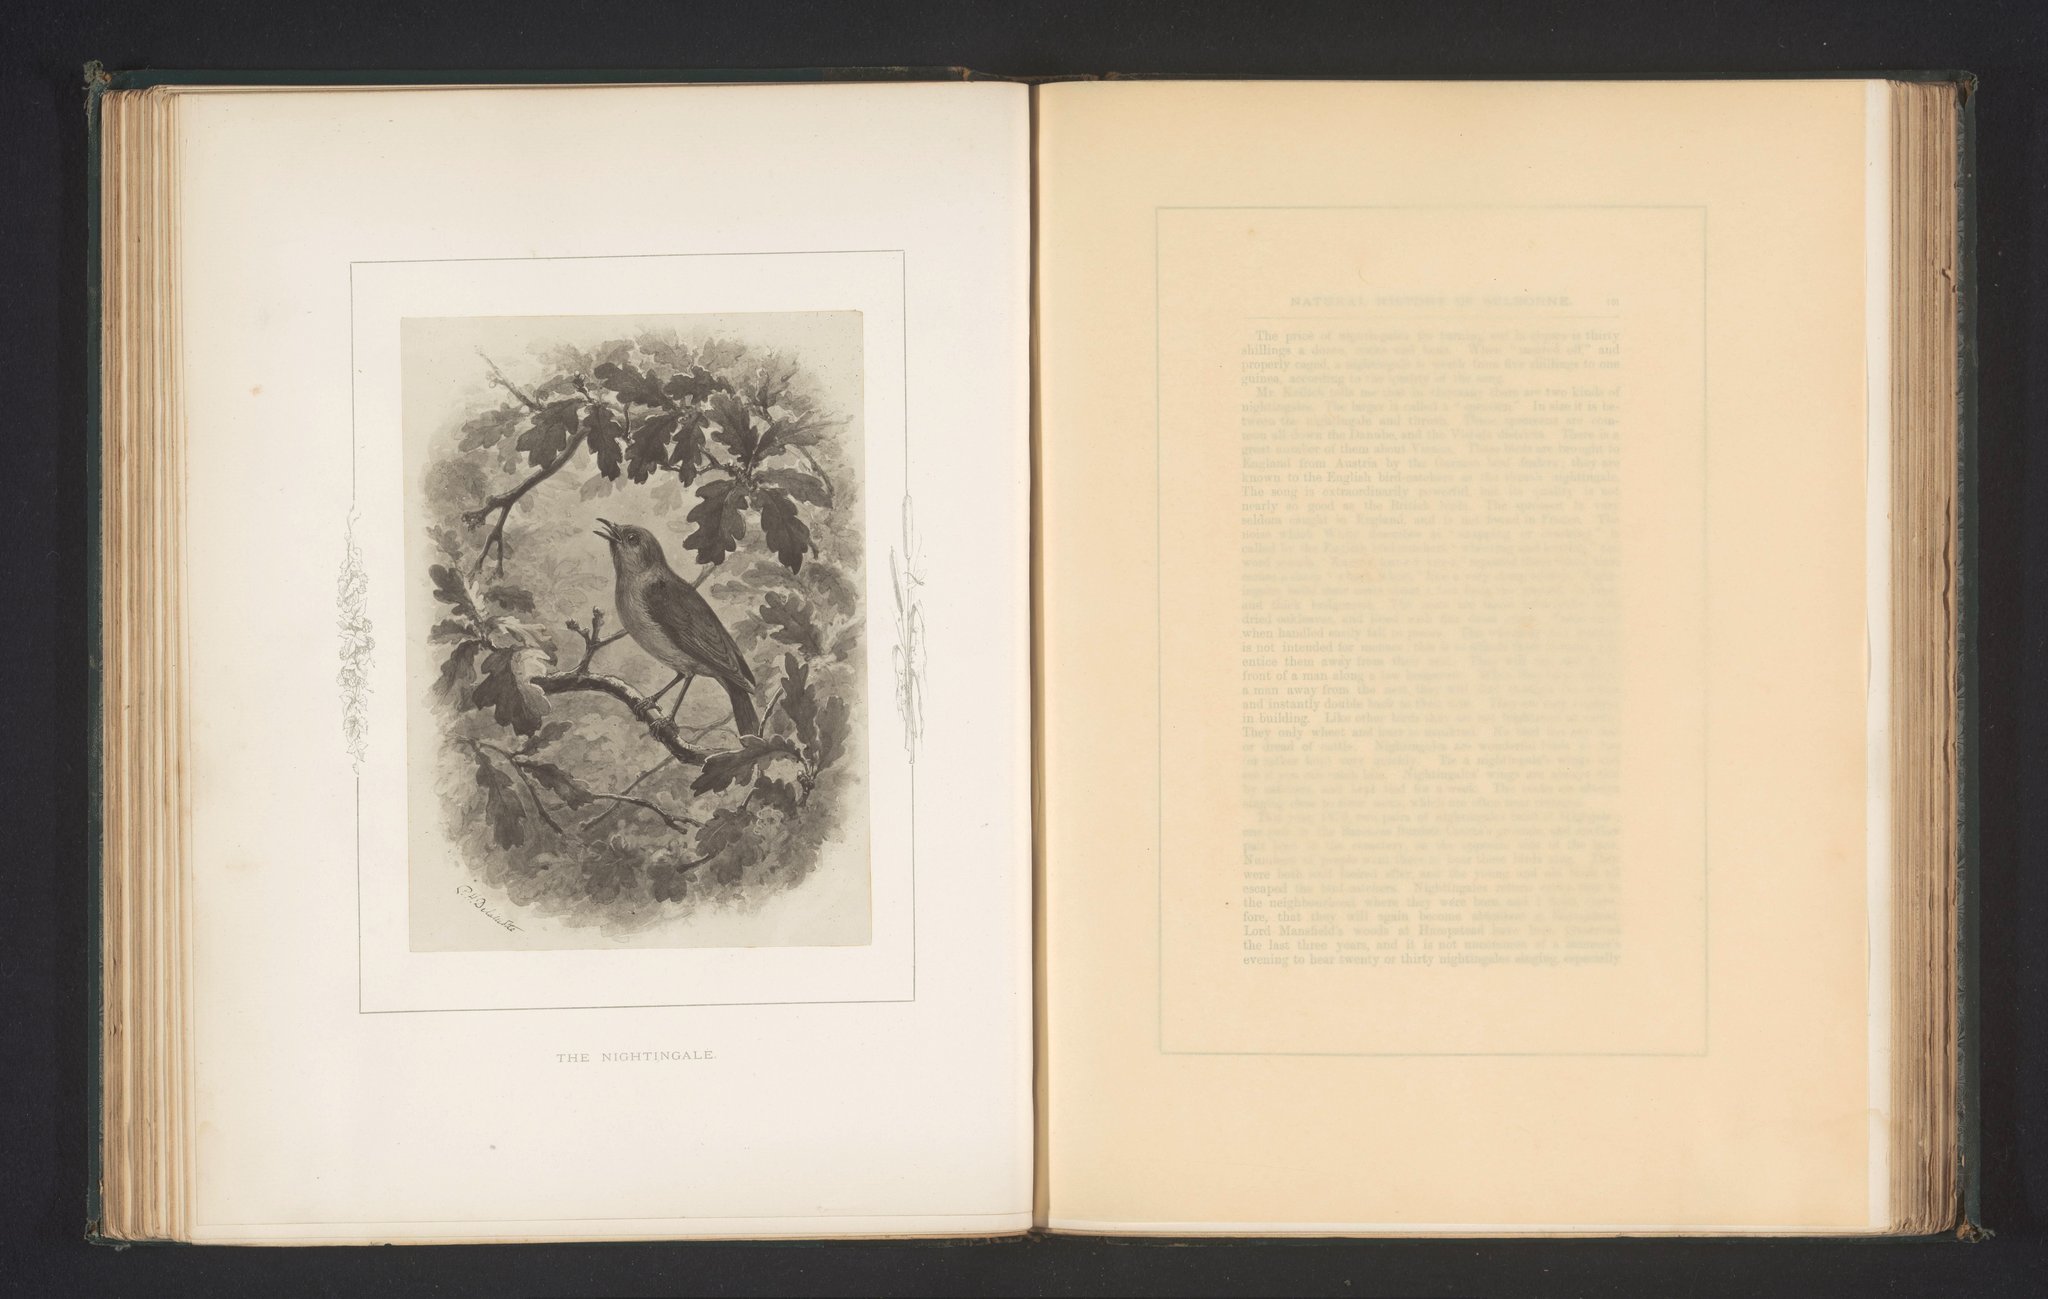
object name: photograph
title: The nightingale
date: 1850-1876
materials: photographic support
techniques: carbon print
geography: selborne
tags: song-birds: nightingale